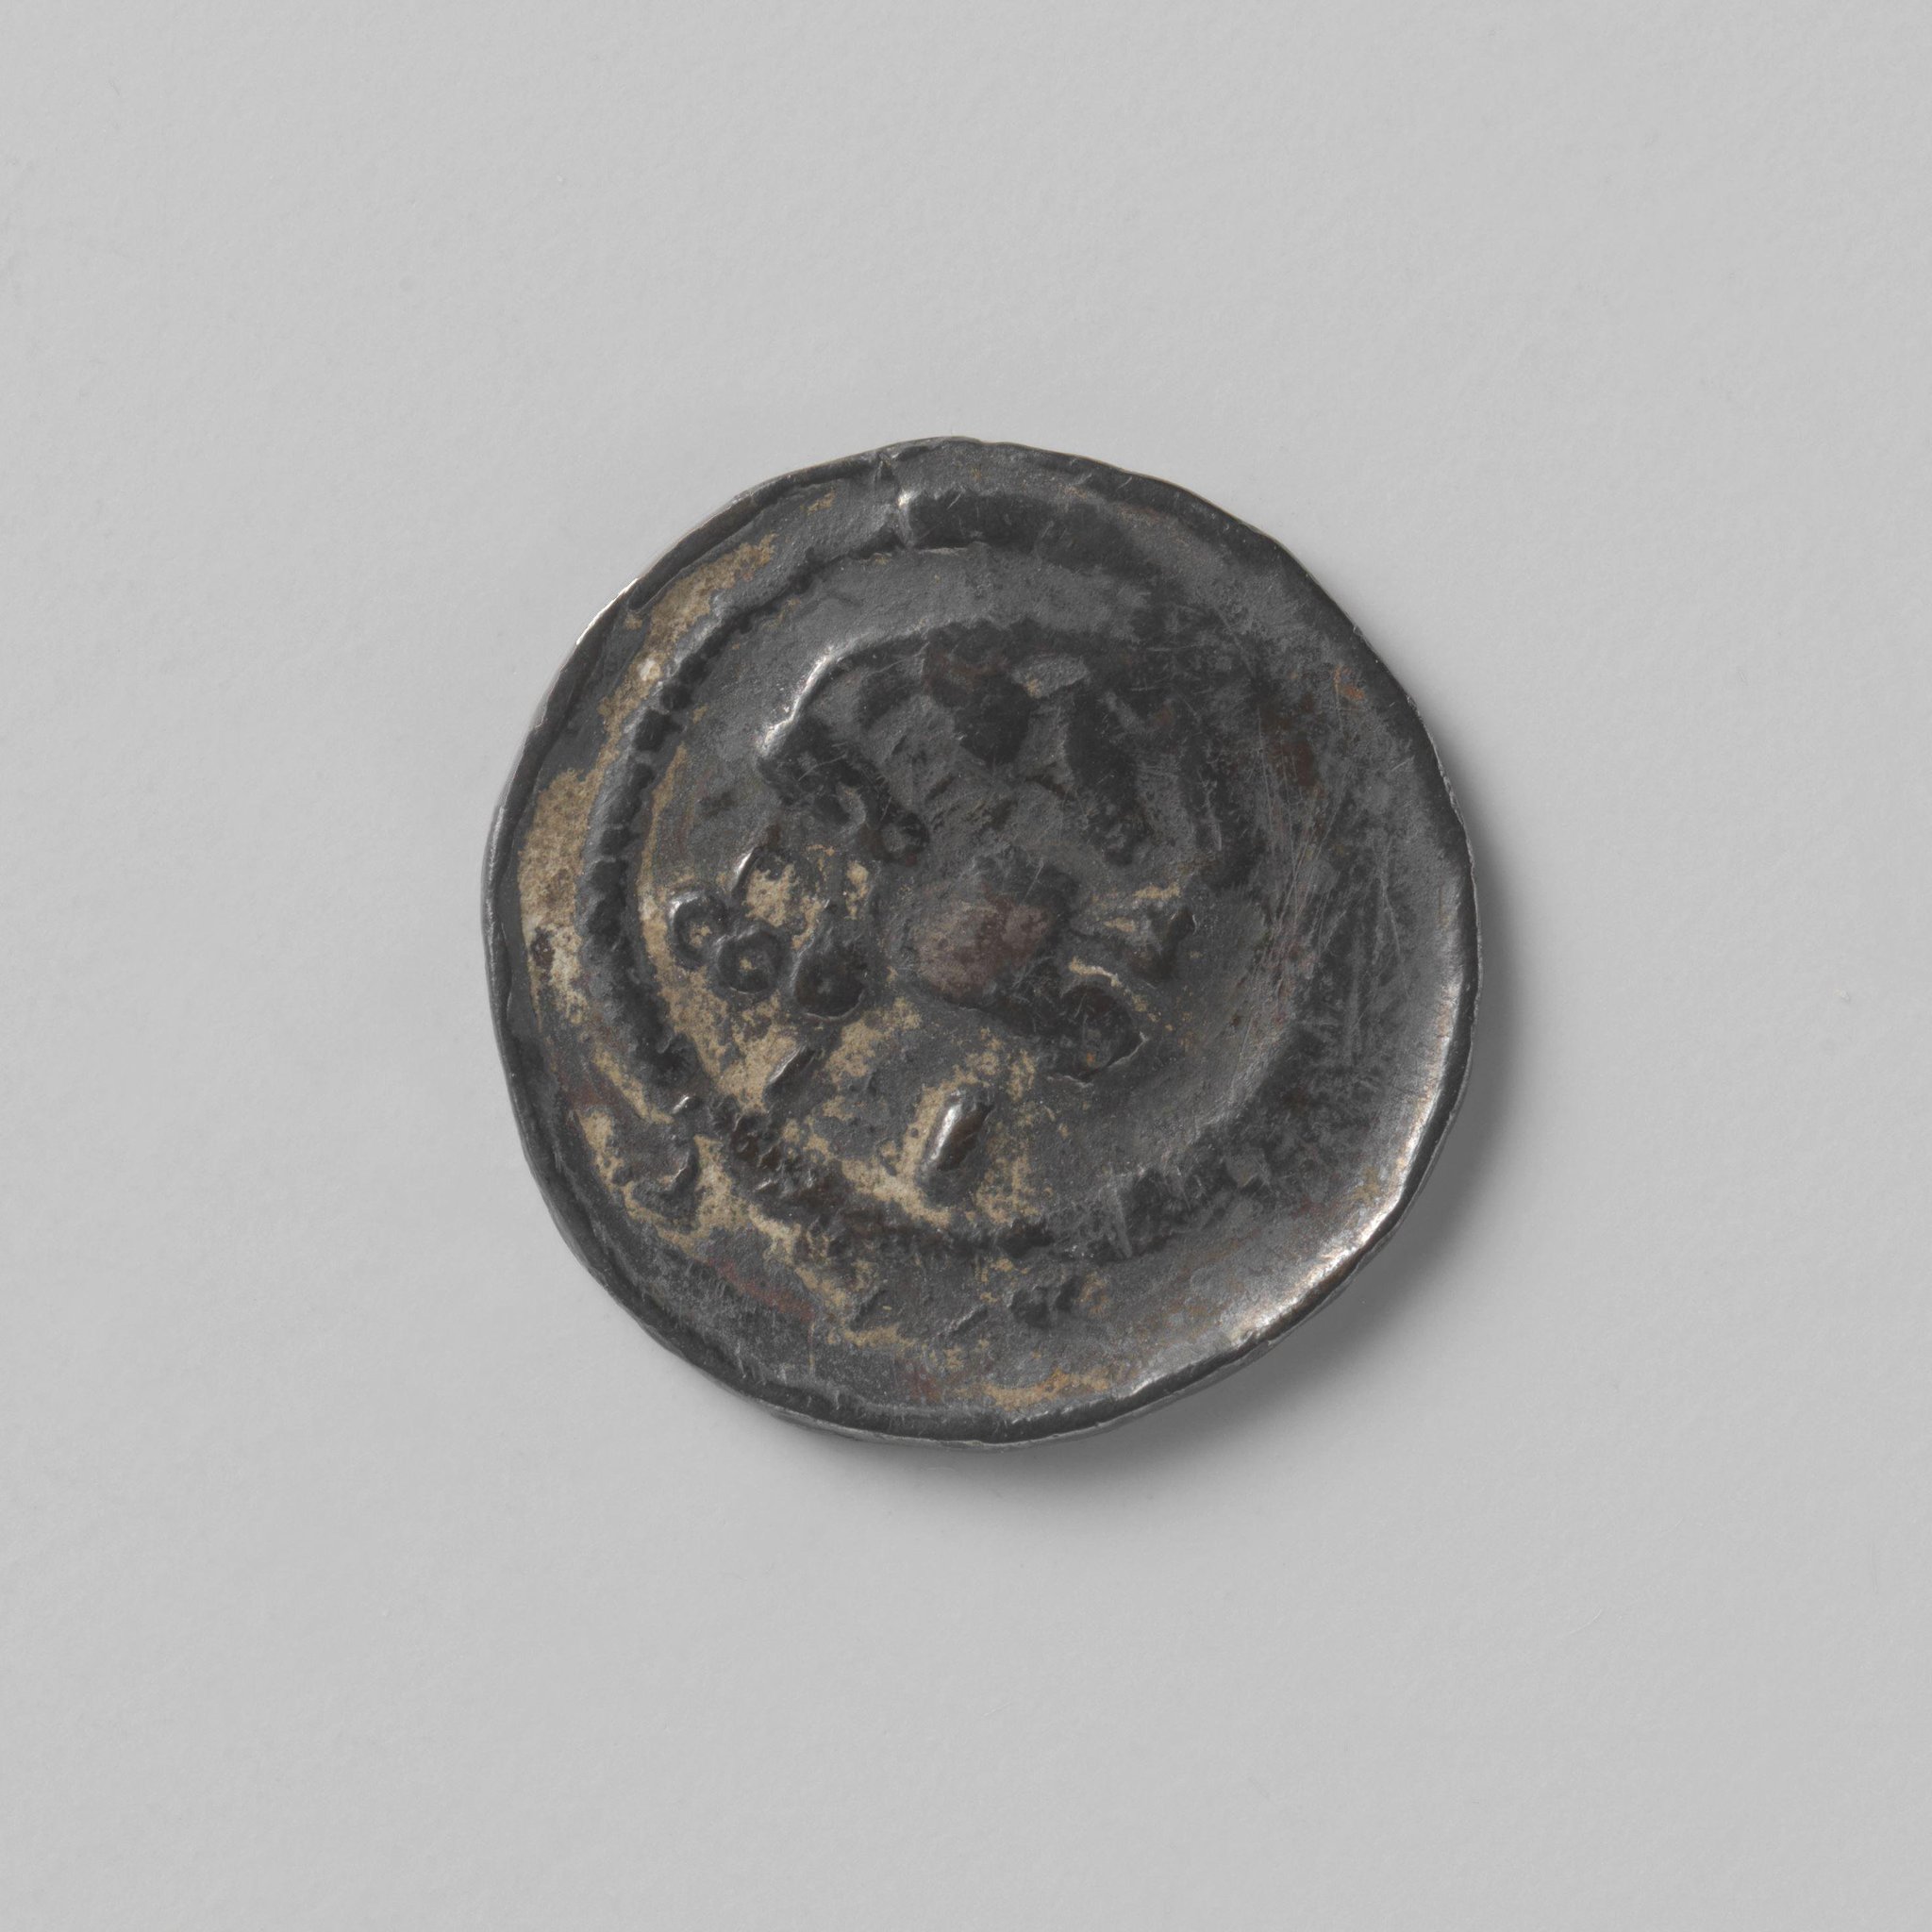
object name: penny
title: Holland, Floris IV, penning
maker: floris iv (graaf van holland)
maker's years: 1210-1234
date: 1222-1234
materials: silver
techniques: striking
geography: dordrecht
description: Zilveren munt. Voorzijde: hoofd met gravenmuts naar rechts. Keerzijde: kort dubbellijnig kruis.